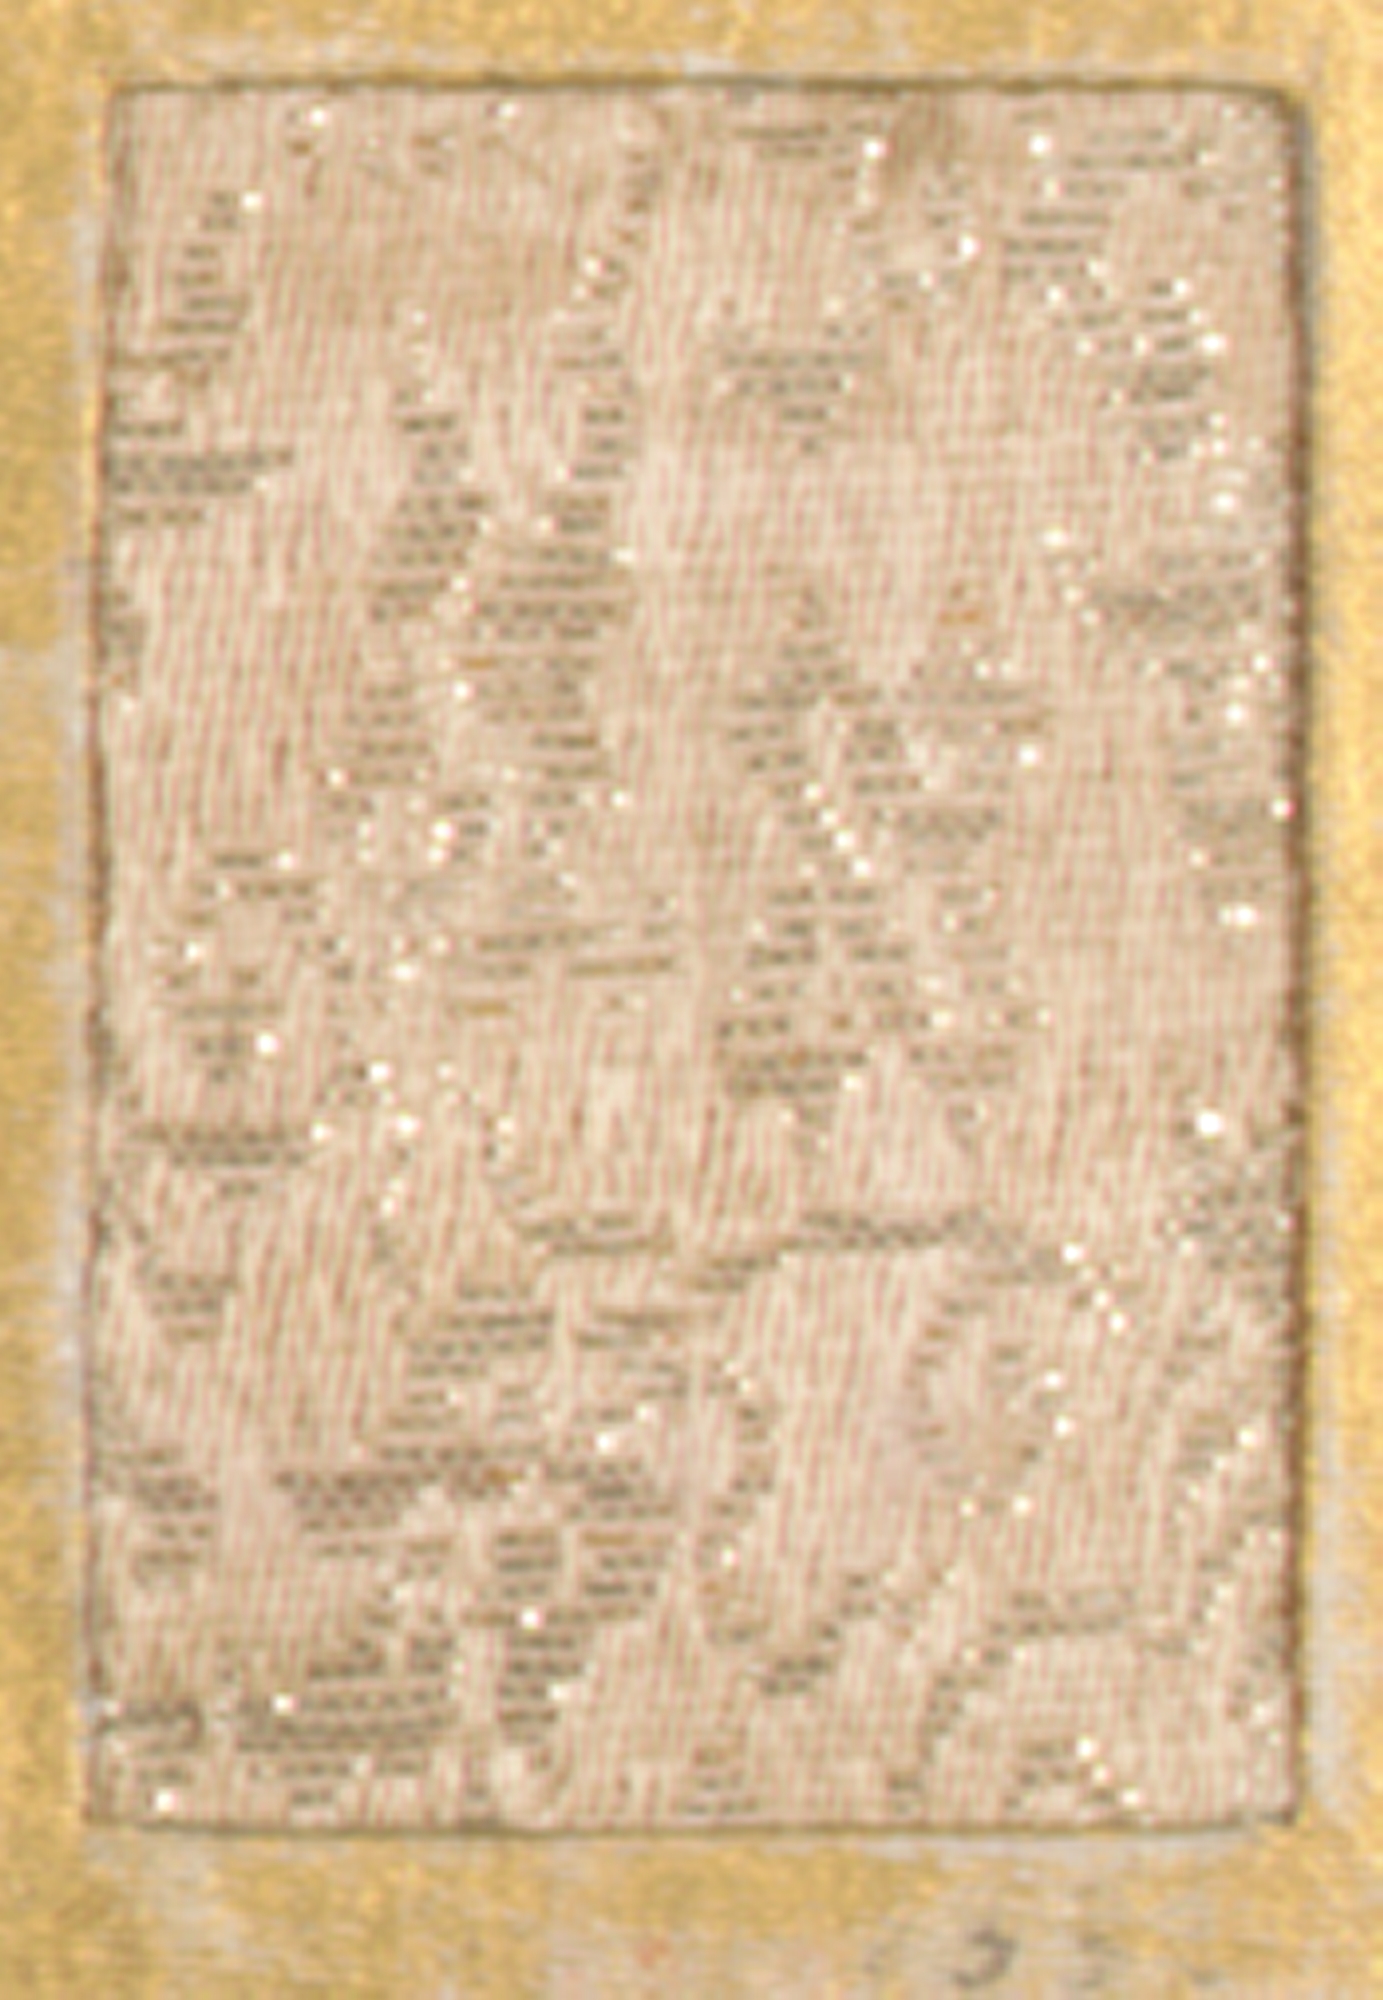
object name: piece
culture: japanese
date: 1701-1900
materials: silk